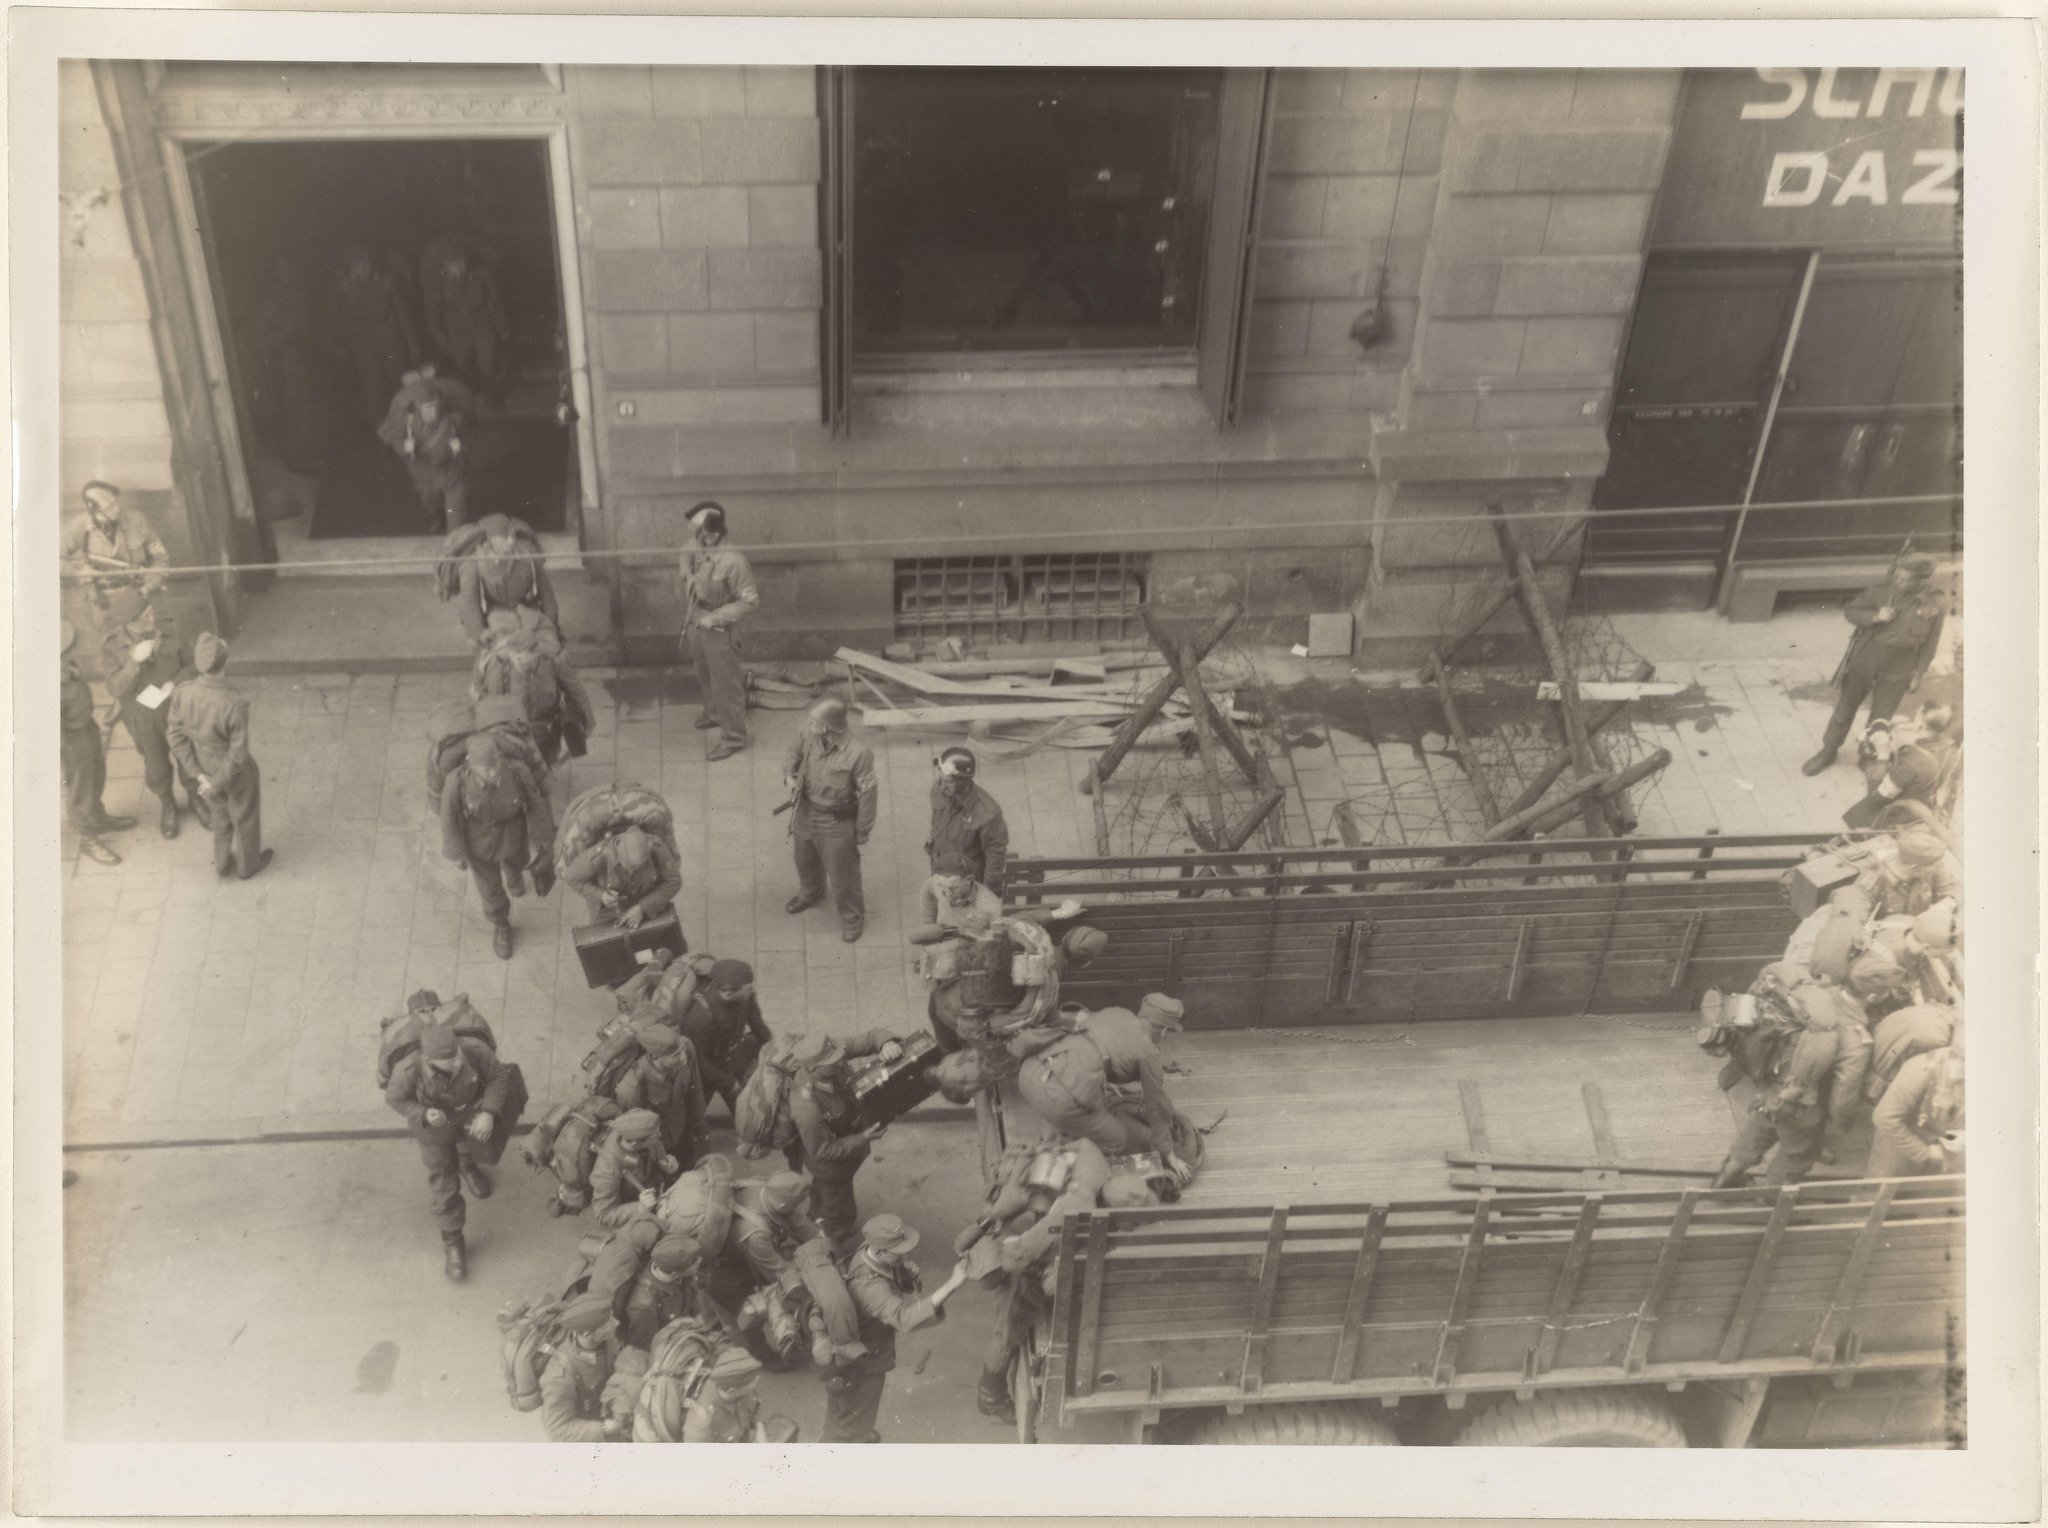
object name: photograph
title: Ontruiming Groote Club door de Binnenlandse Strijdkrachten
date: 1945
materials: photographic support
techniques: photography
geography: amsterdam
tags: amsterdam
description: Legervoertuigen staan voor de Groote Club (hoek Kalverstraat / Dam) van waaruit op 7 mei door de Kriegsmarine was geschoten op de menigte op de Dam. Leden van de Kriegsmarine worden door de Binnenlandse Strijdkrachten gearresteerd en afgevoerd. Vermoedelijk gebeurde dit een dag na de schietpartij, dus op 8 mei.